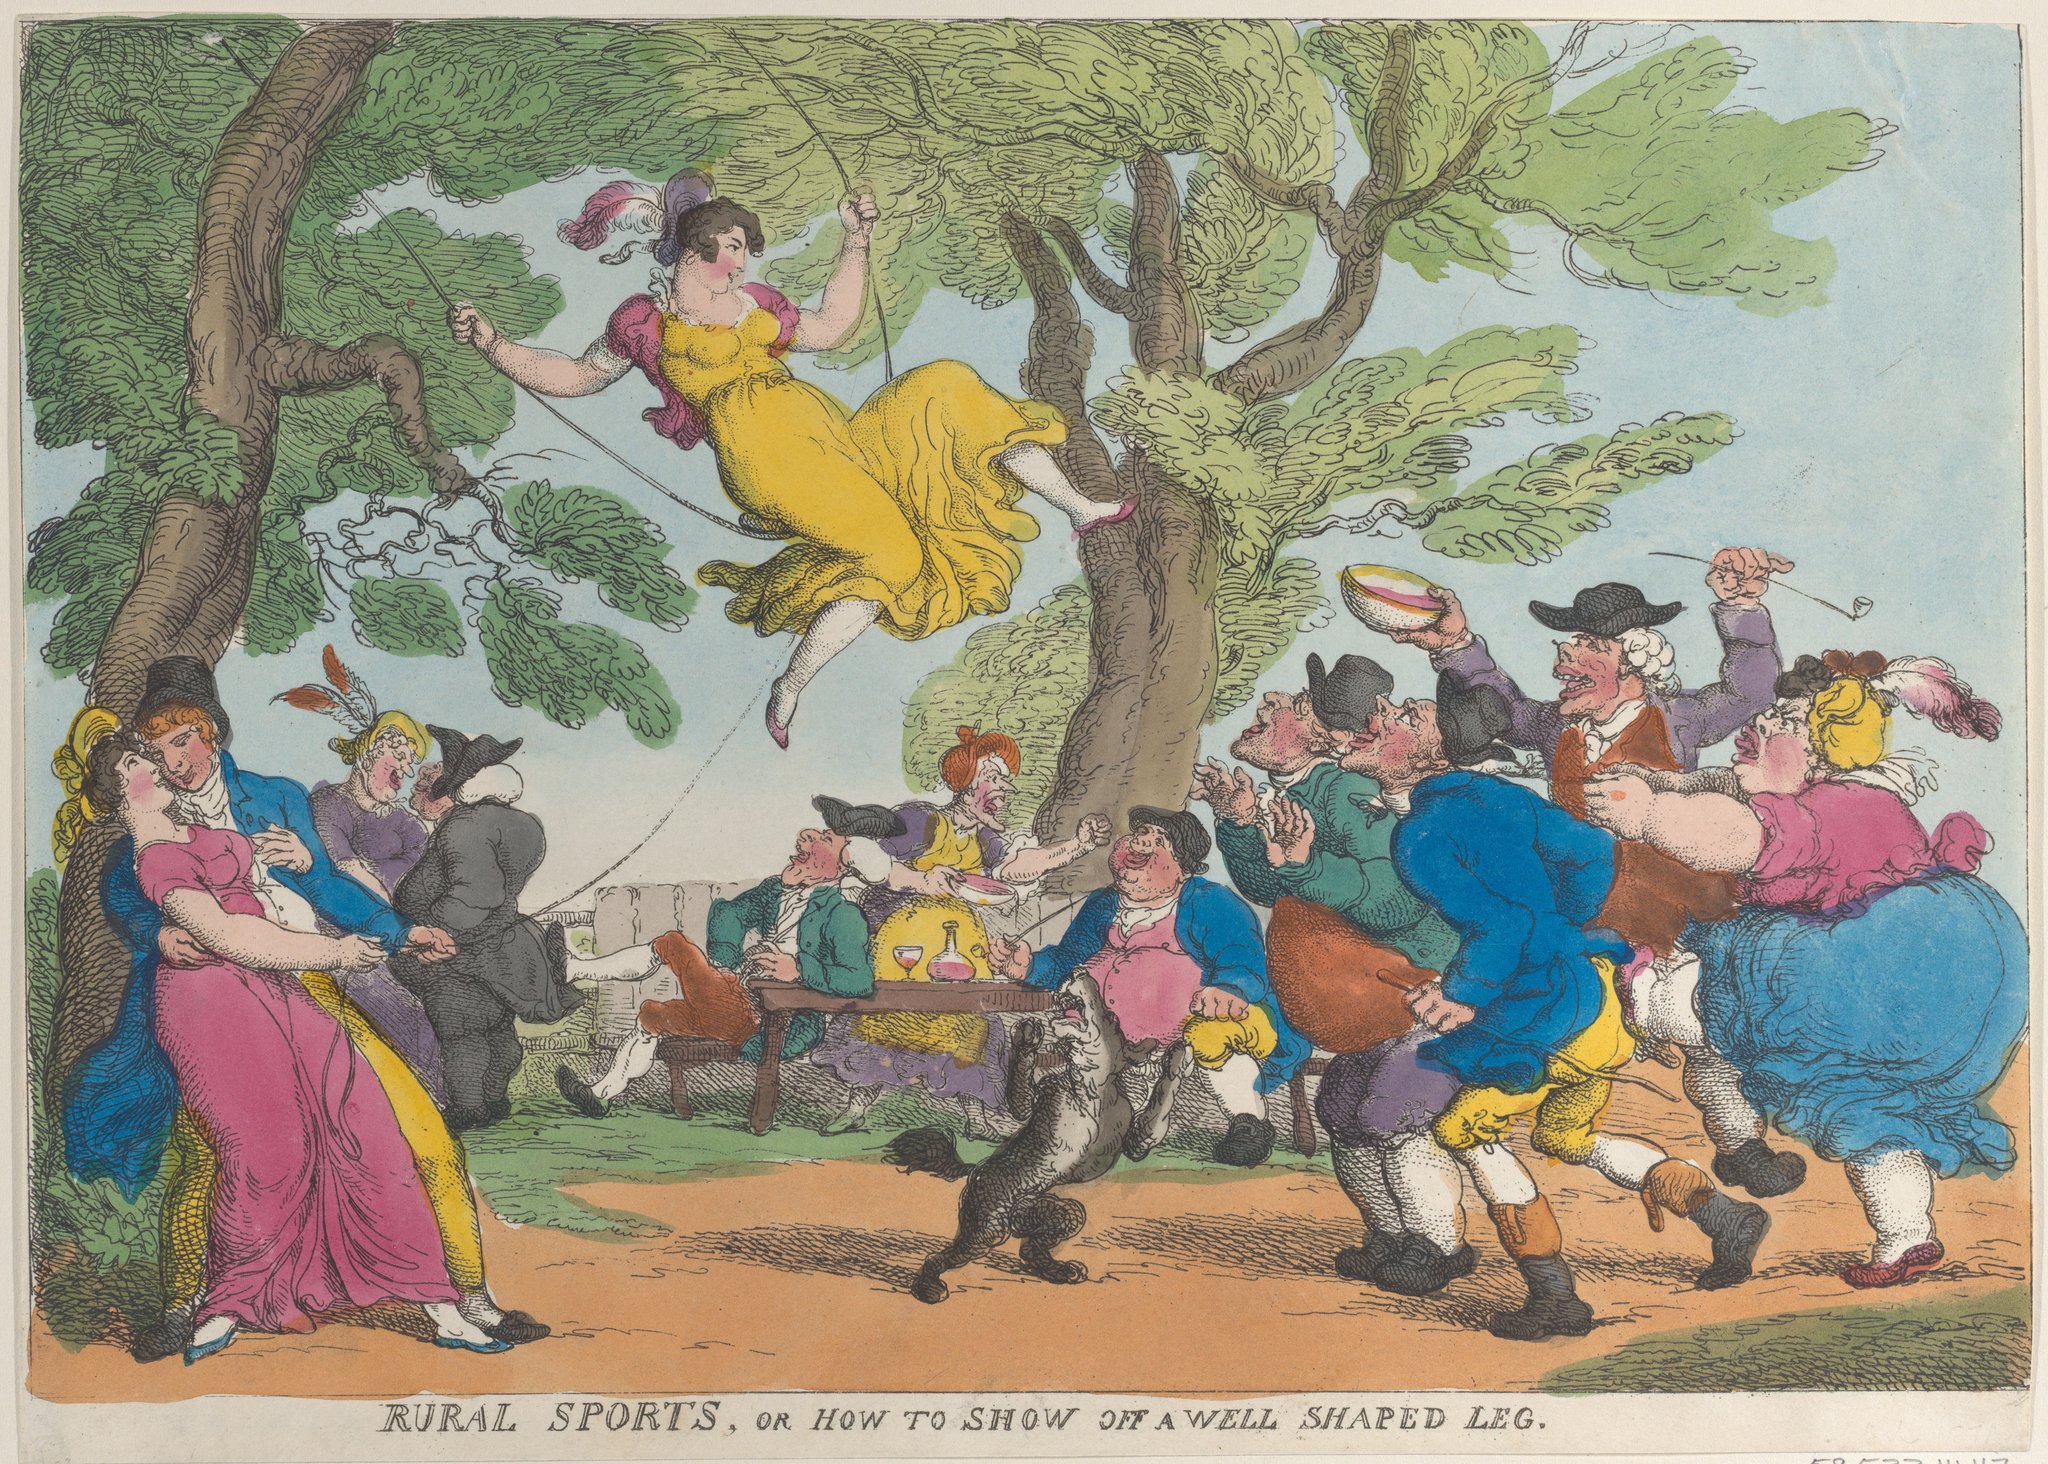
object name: print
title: Rural Sports, or How to Show Off a Well Shaped Leg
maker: thomas rowlandson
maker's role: artist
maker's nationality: british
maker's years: 1757-1827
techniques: etching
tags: satire,men,women,dogs